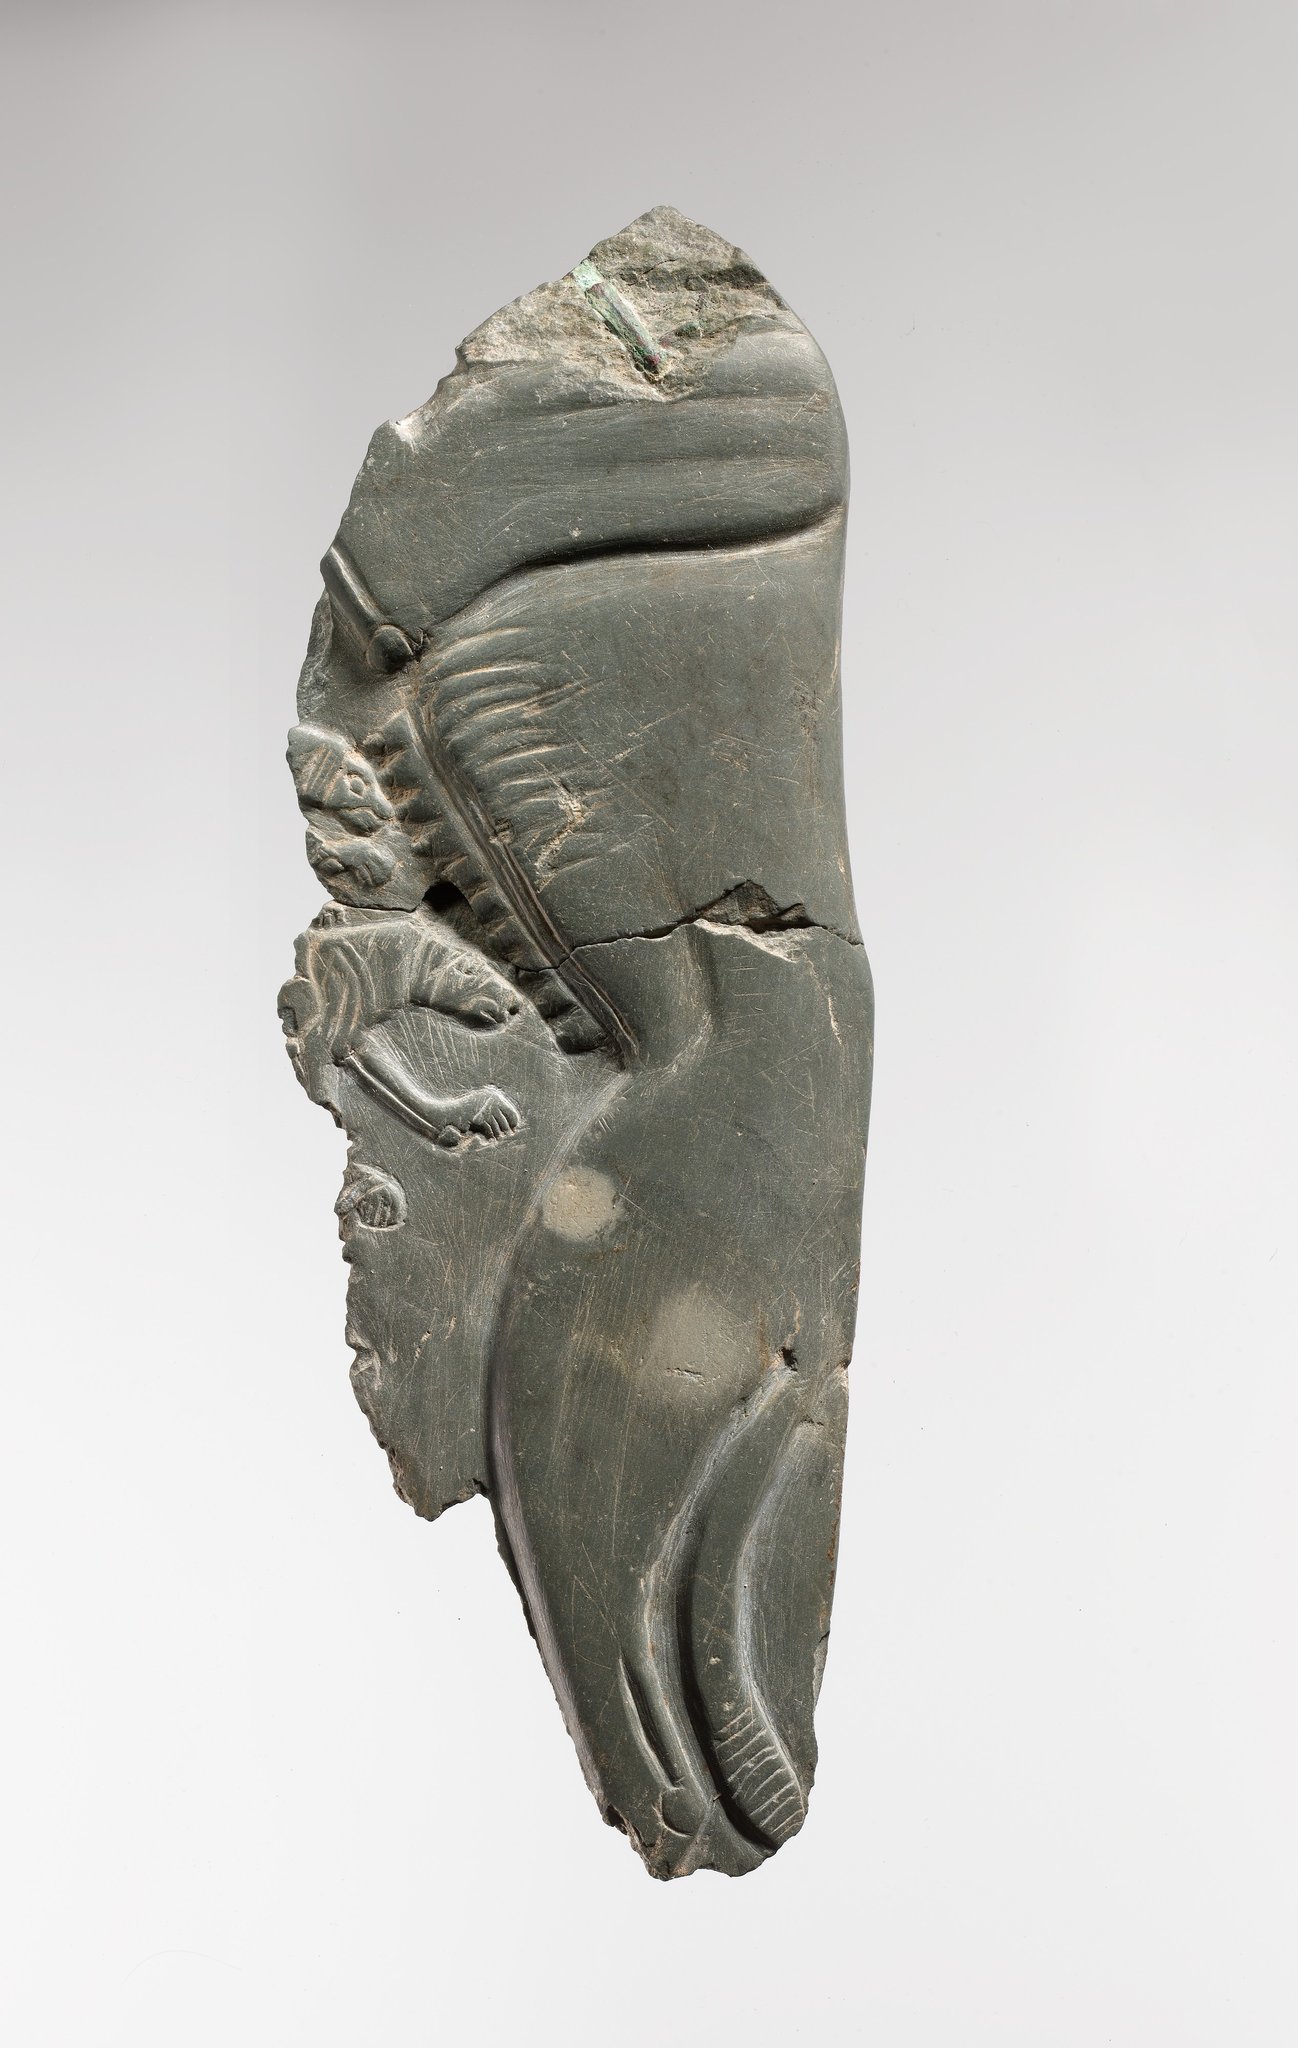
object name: palette, fragment, hunting dog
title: Palette Fragment Illustrating a Wild Dog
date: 3300-3100 BCE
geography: eastern delta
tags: dogs